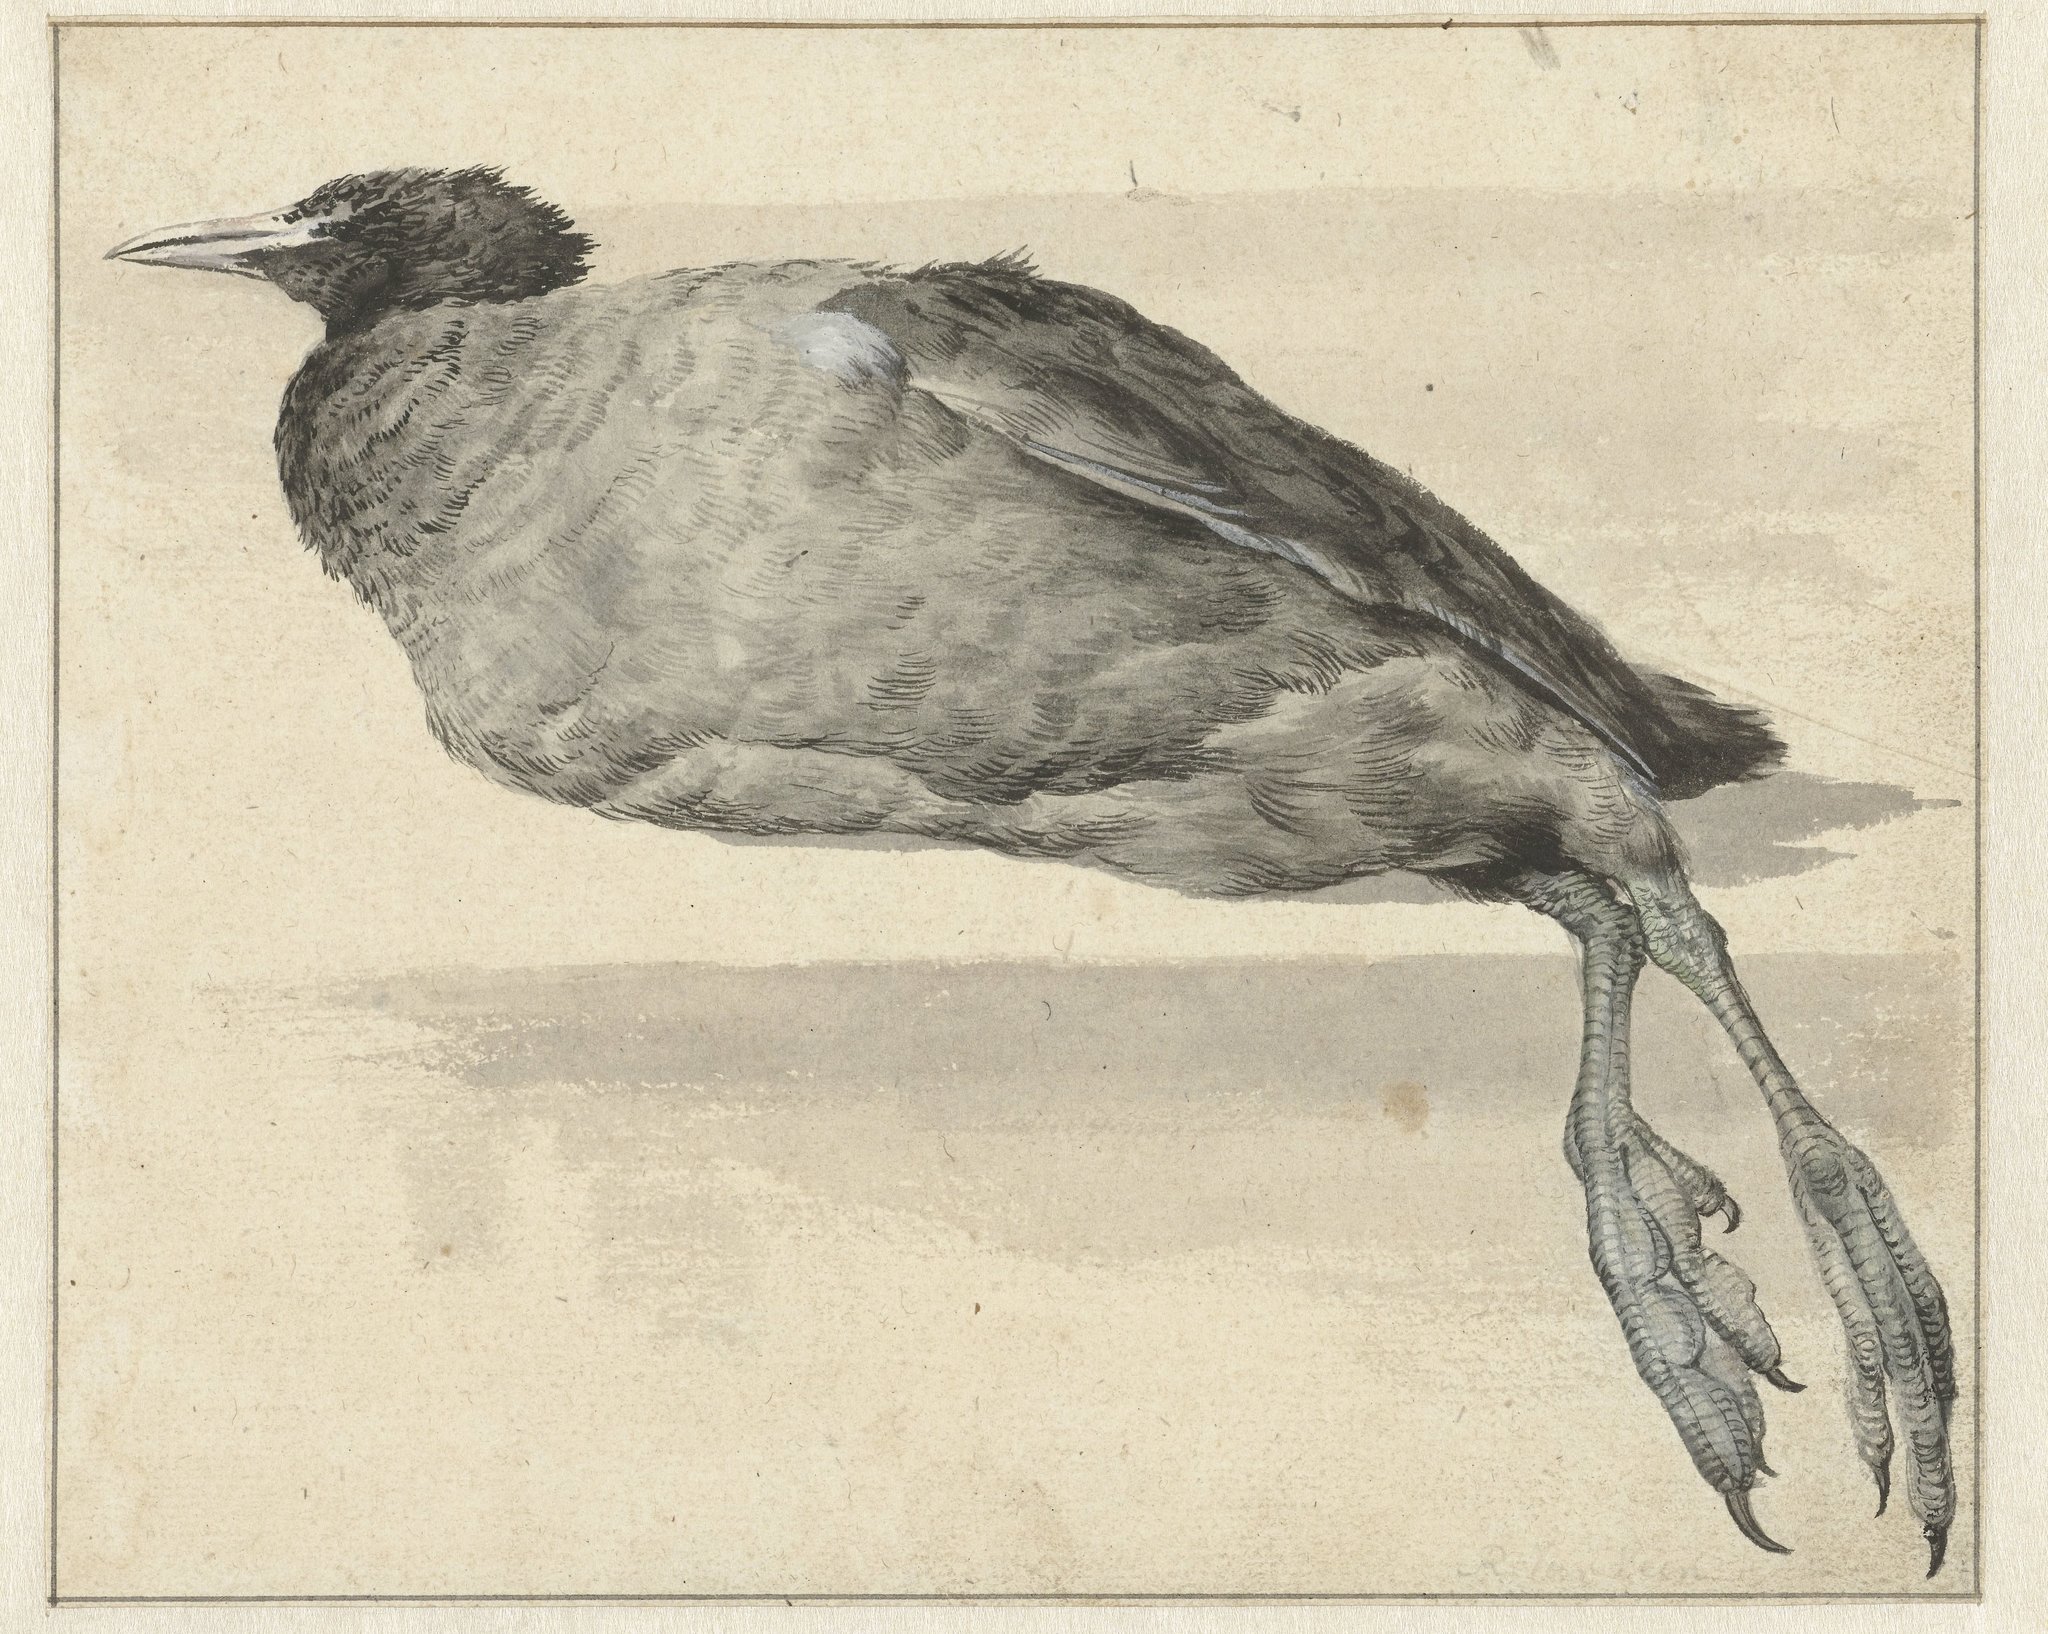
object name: drawing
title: Dode meerkoet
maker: rochus van veen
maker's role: draughtsman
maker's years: 1640-1693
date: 1649-1709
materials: paint, paper, watercolor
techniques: brush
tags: water-birds: coot (+ dying animal; death of animal; dead animal)